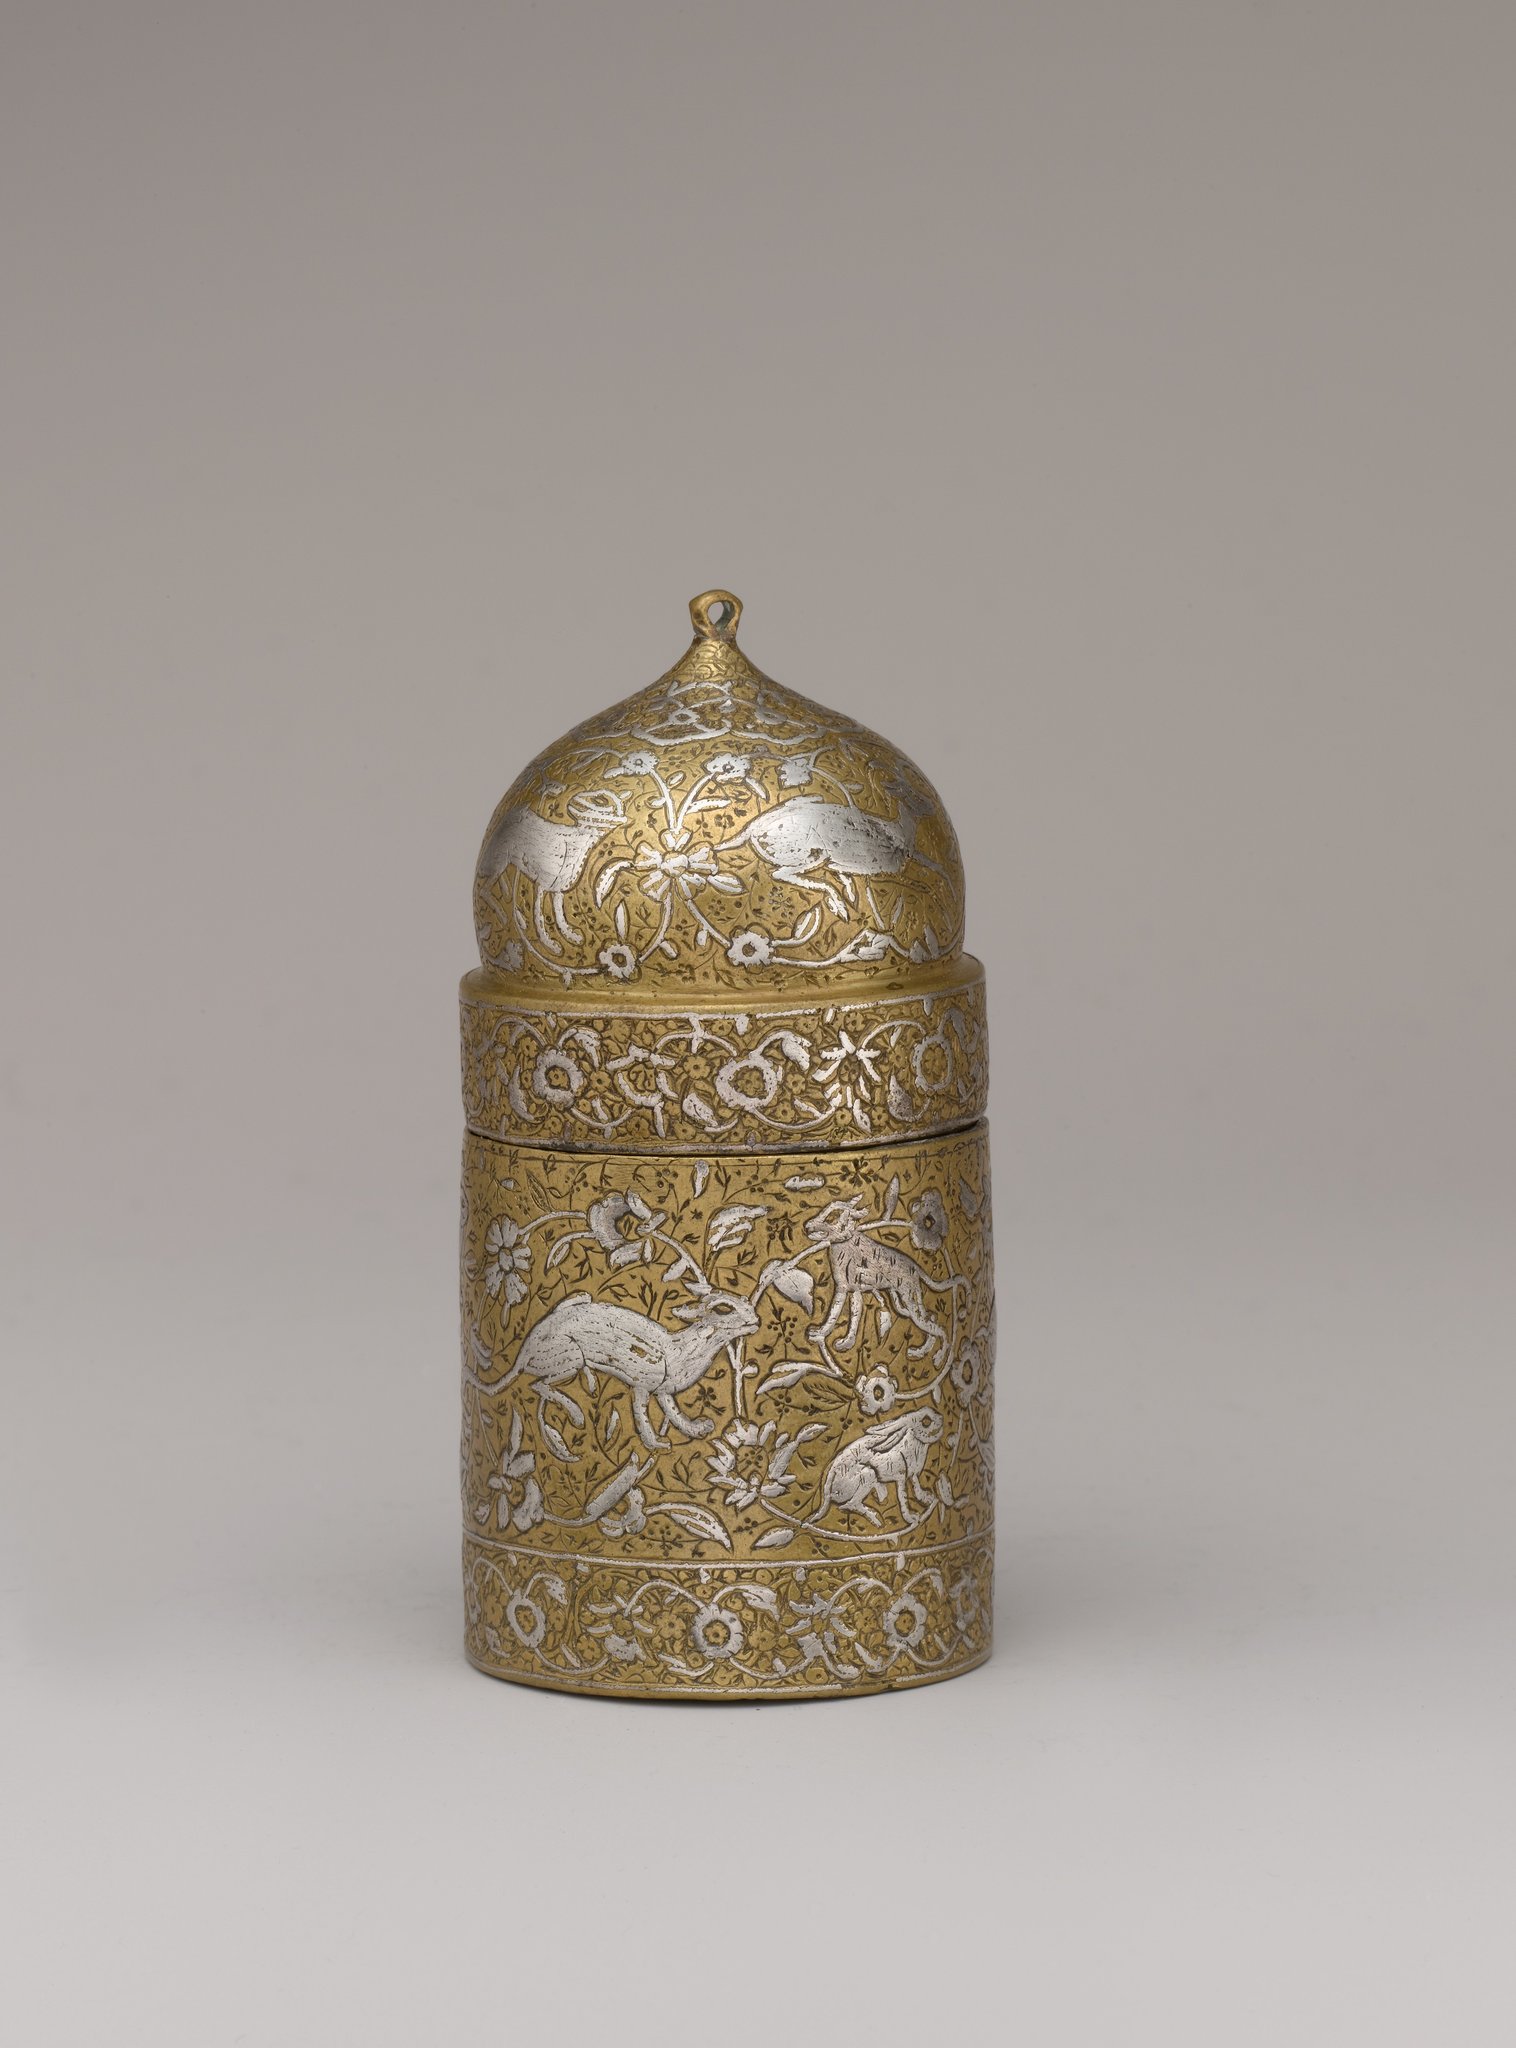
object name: inkwell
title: Inkwell with Floral and Animal Imagery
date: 1501-1600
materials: brass, silver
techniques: casting, chasing, engraving, inlay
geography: iran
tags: deer,dogs,rabbits,flowers,vines